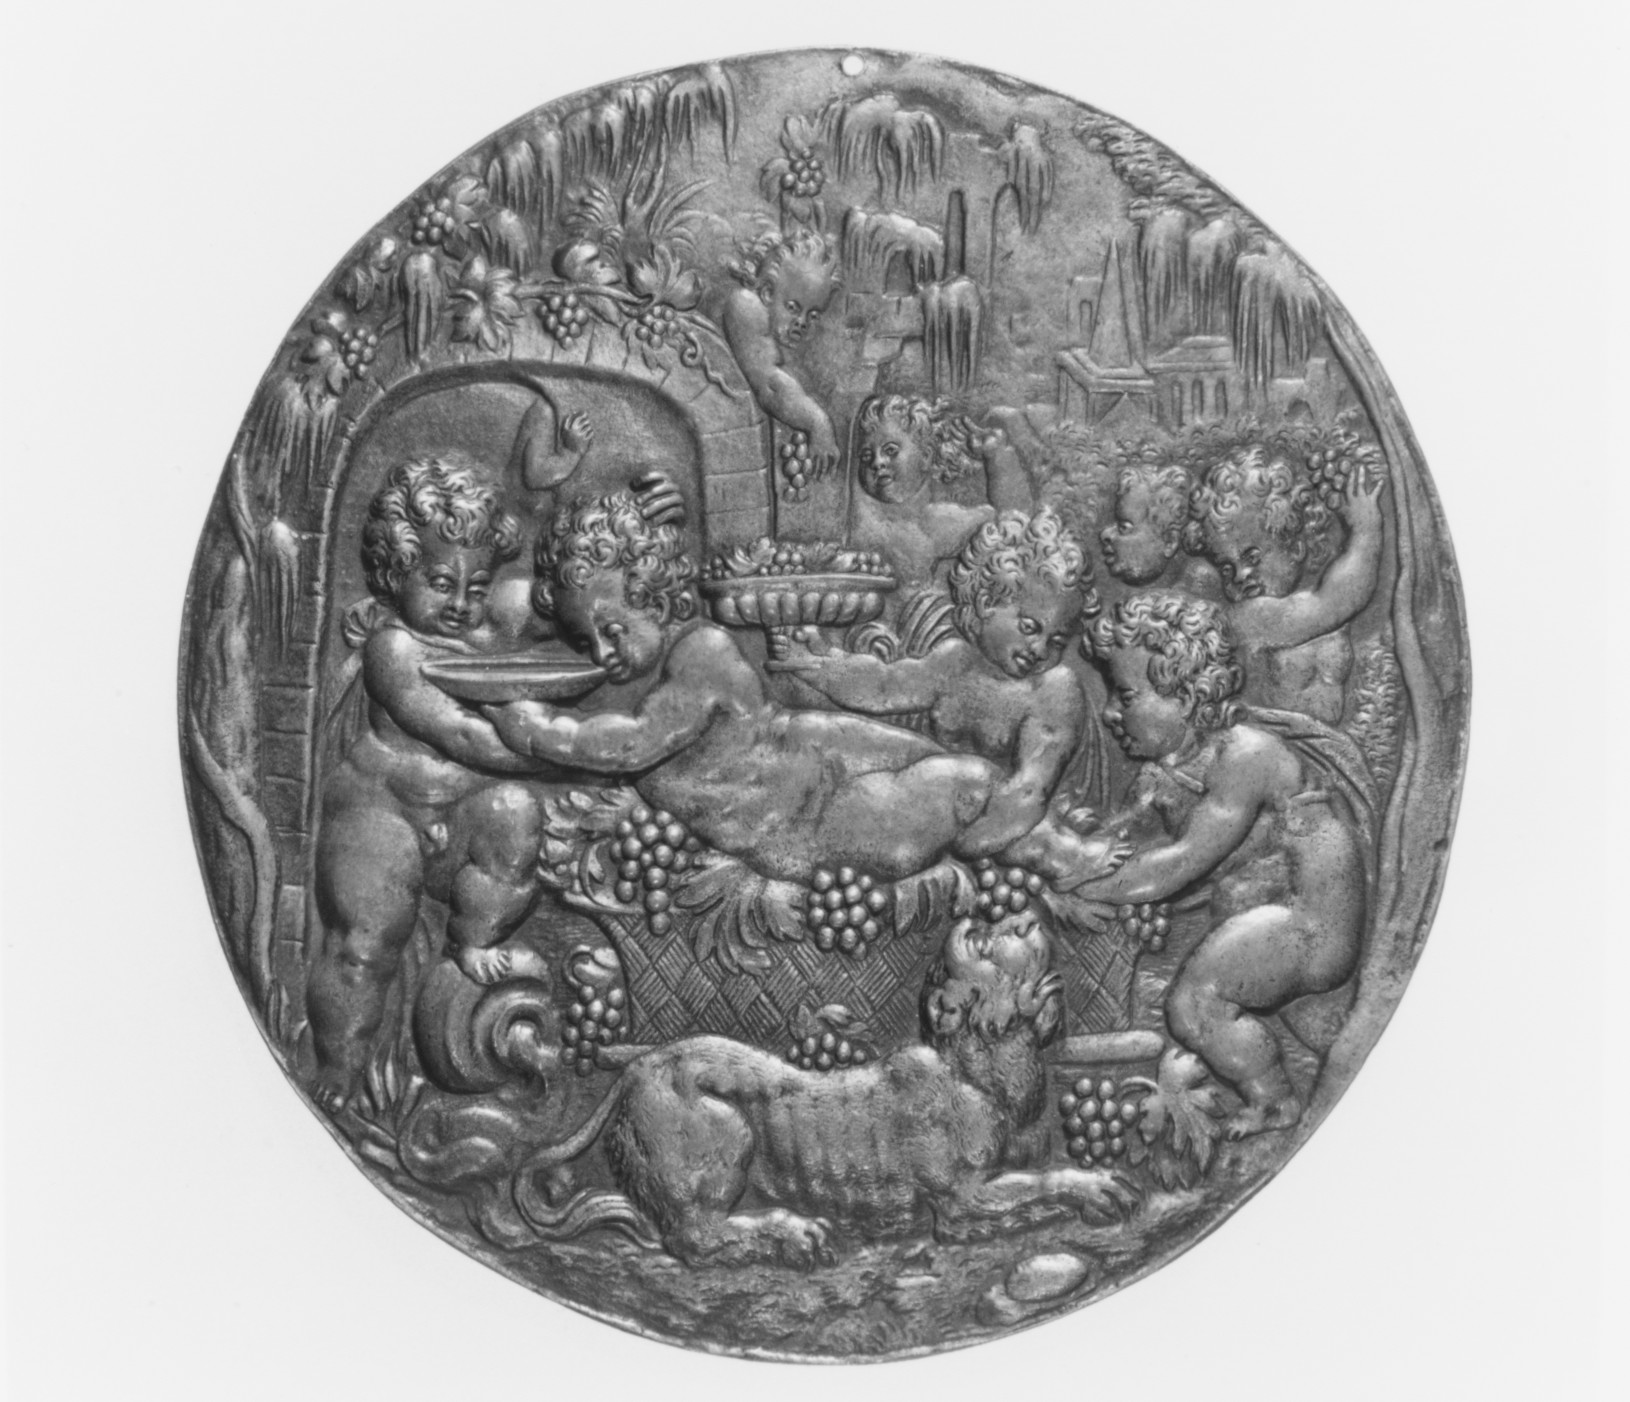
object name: plaquette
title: Bacchanal of Putti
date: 1567-1600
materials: bronze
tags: grapes,putti,lions